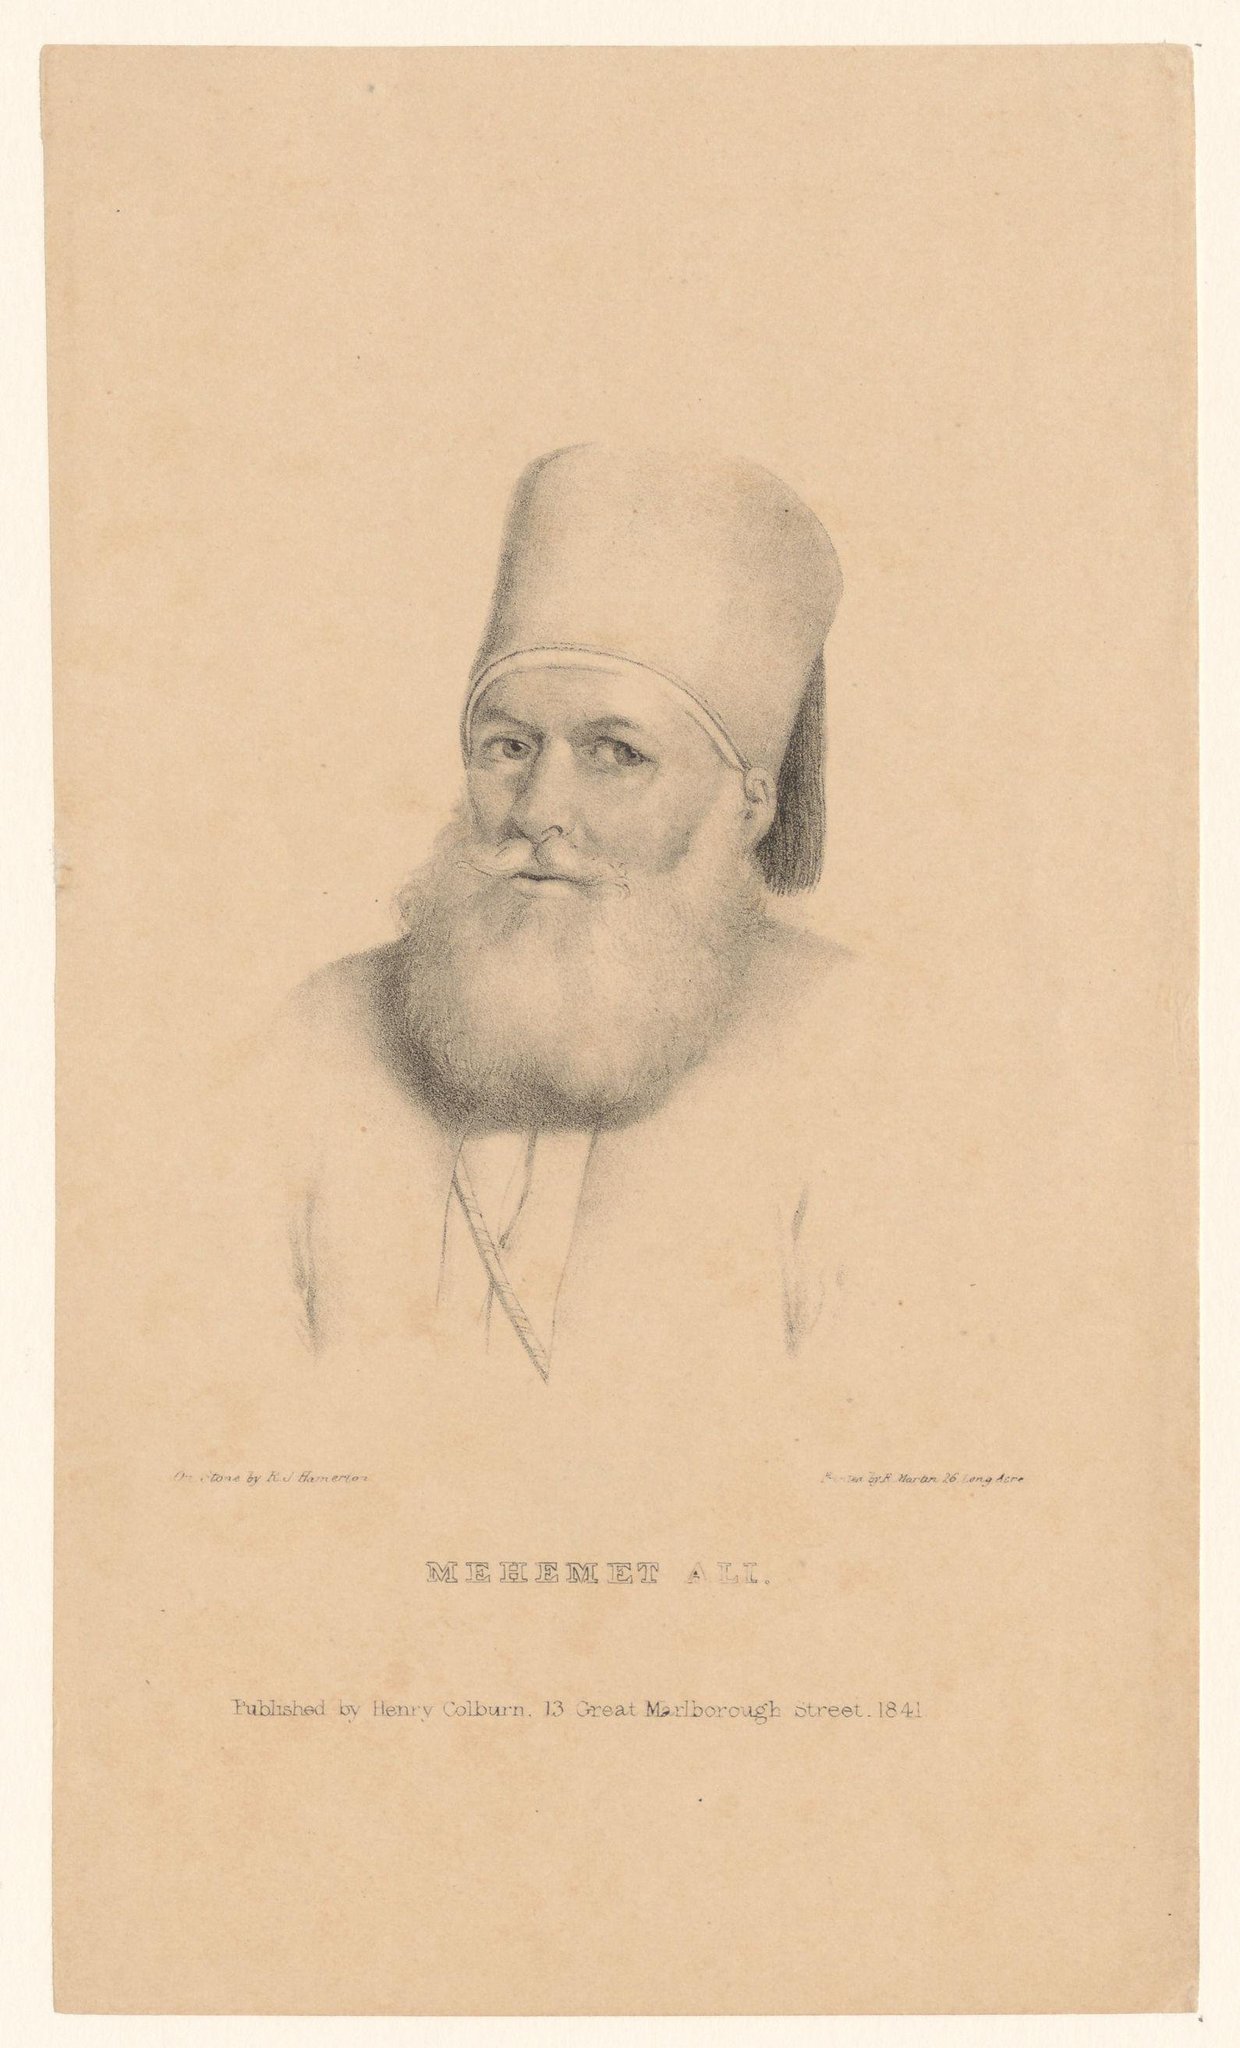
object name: print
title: Mehemet Ali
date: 1841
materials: paper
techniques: lithograph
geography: london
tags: head-gear, adult man, historical persons, beard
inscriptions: collector's mark: Lugt 2228